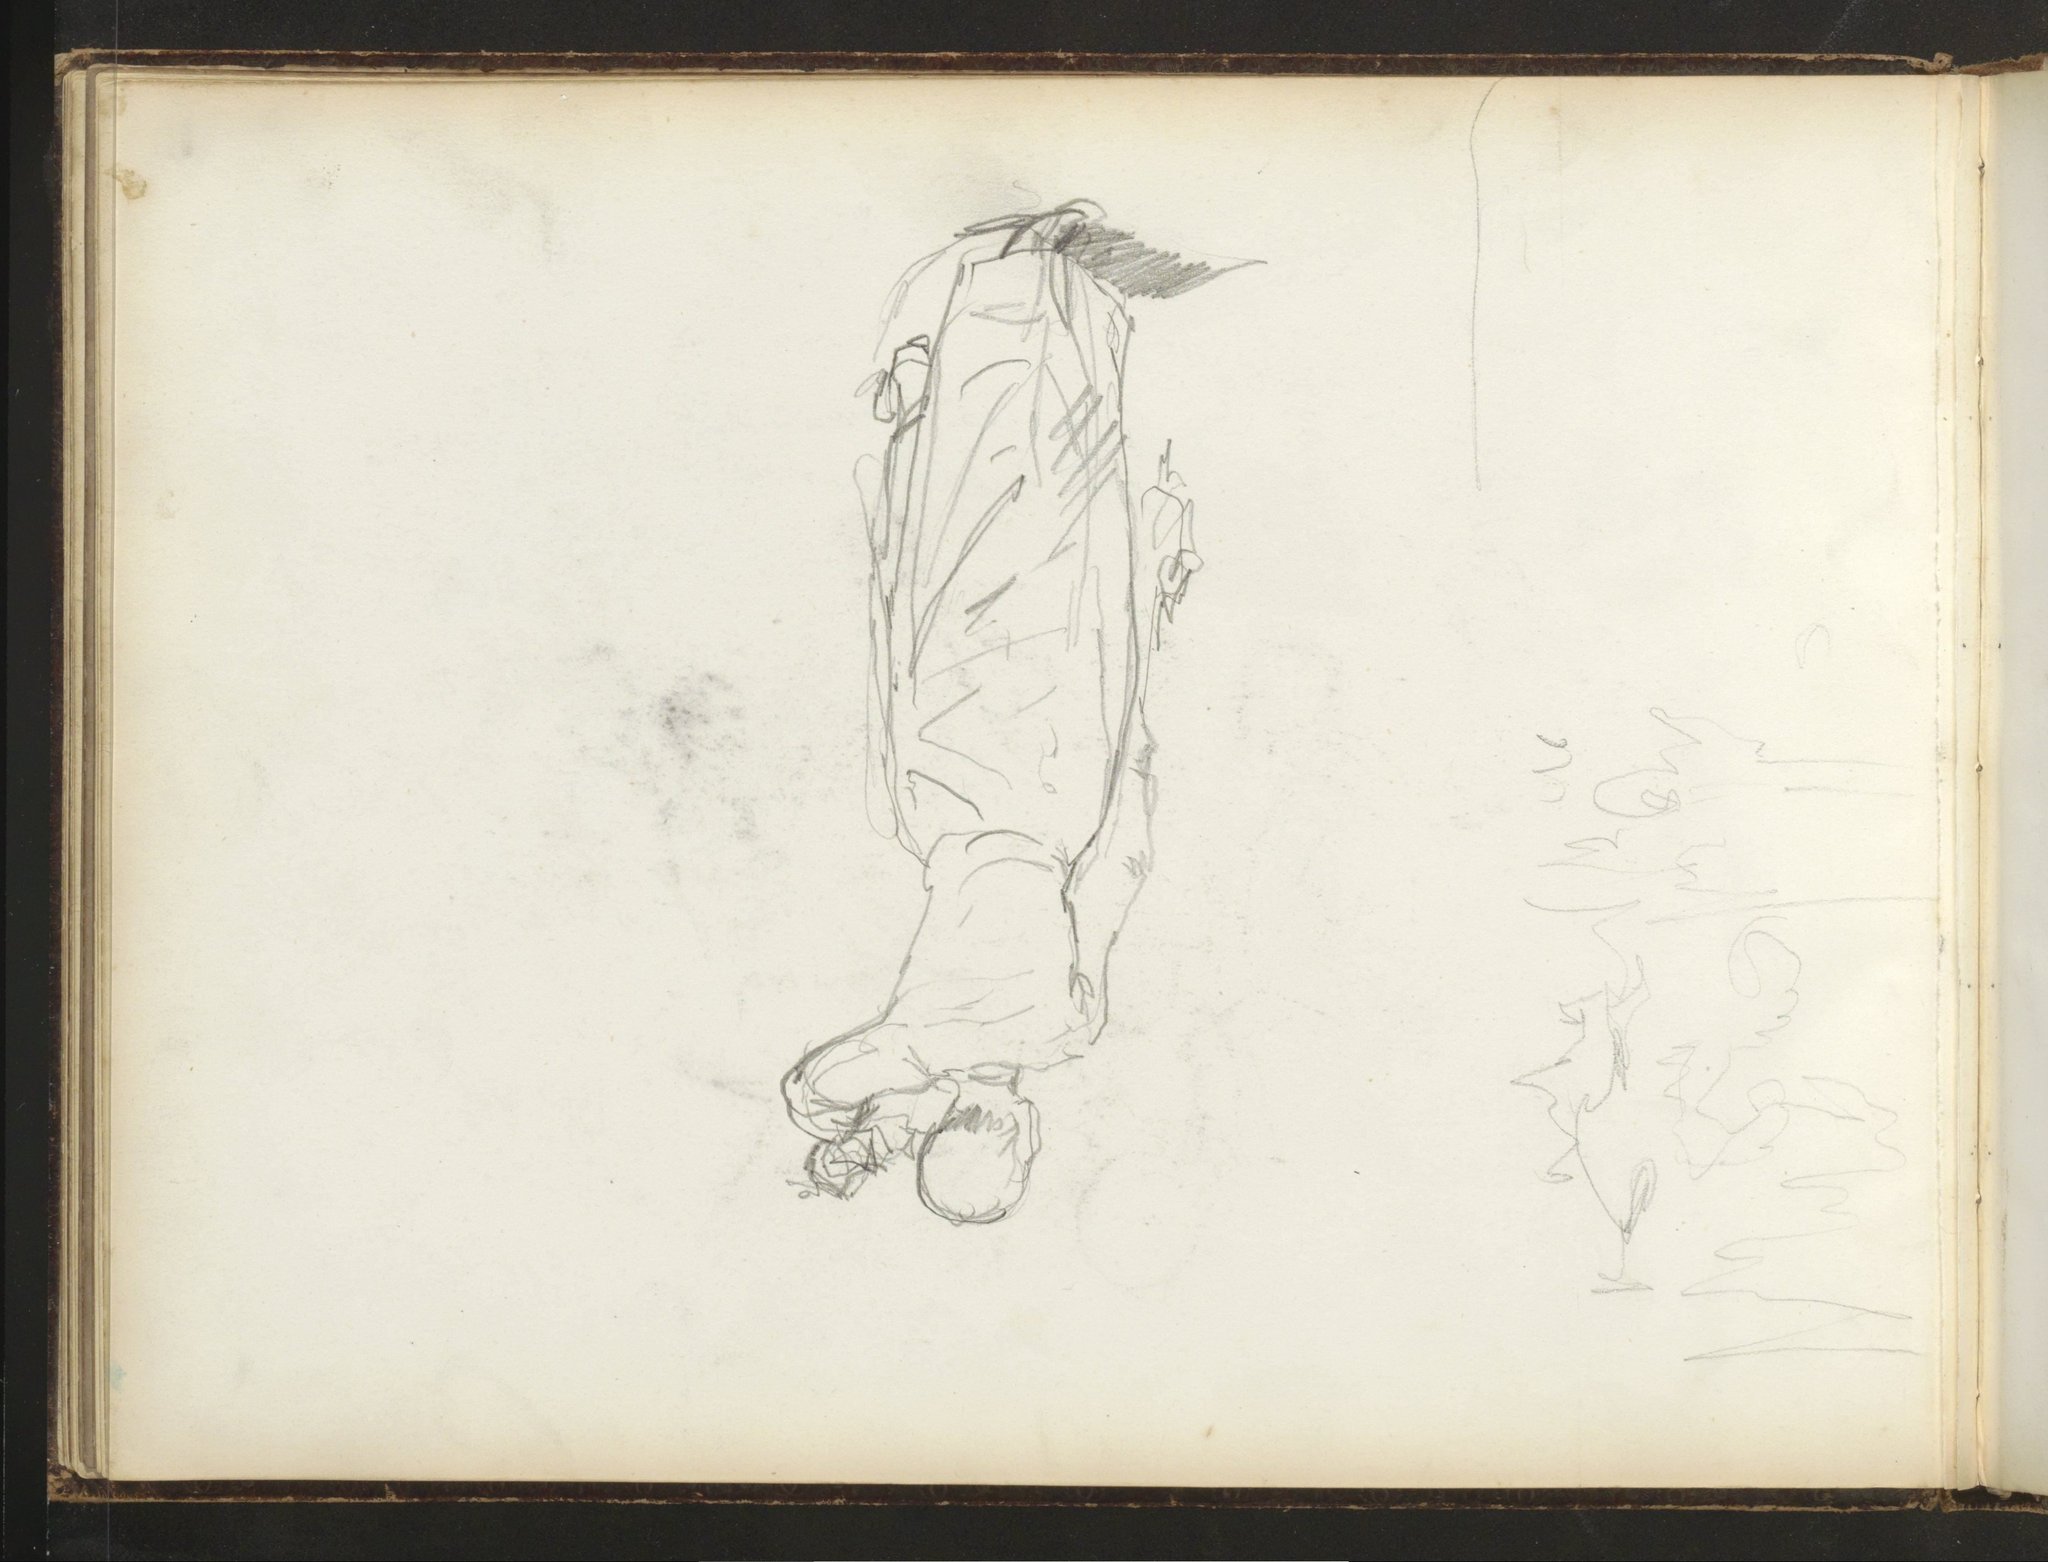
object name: sketchbook leaf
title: Vrouw in een lange jurk, van achteren gezien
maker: reinier craeyvanger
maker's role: draughtsman, print maker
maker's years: 1812-1880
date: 1822-1880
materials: paper, pencil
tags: arm raised upward, standing figure - aa - female human figure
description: De vrouw heeft de rechter bovenarm opgeheven. Blad 22 verso uit een schetsboek met 45 bladen.